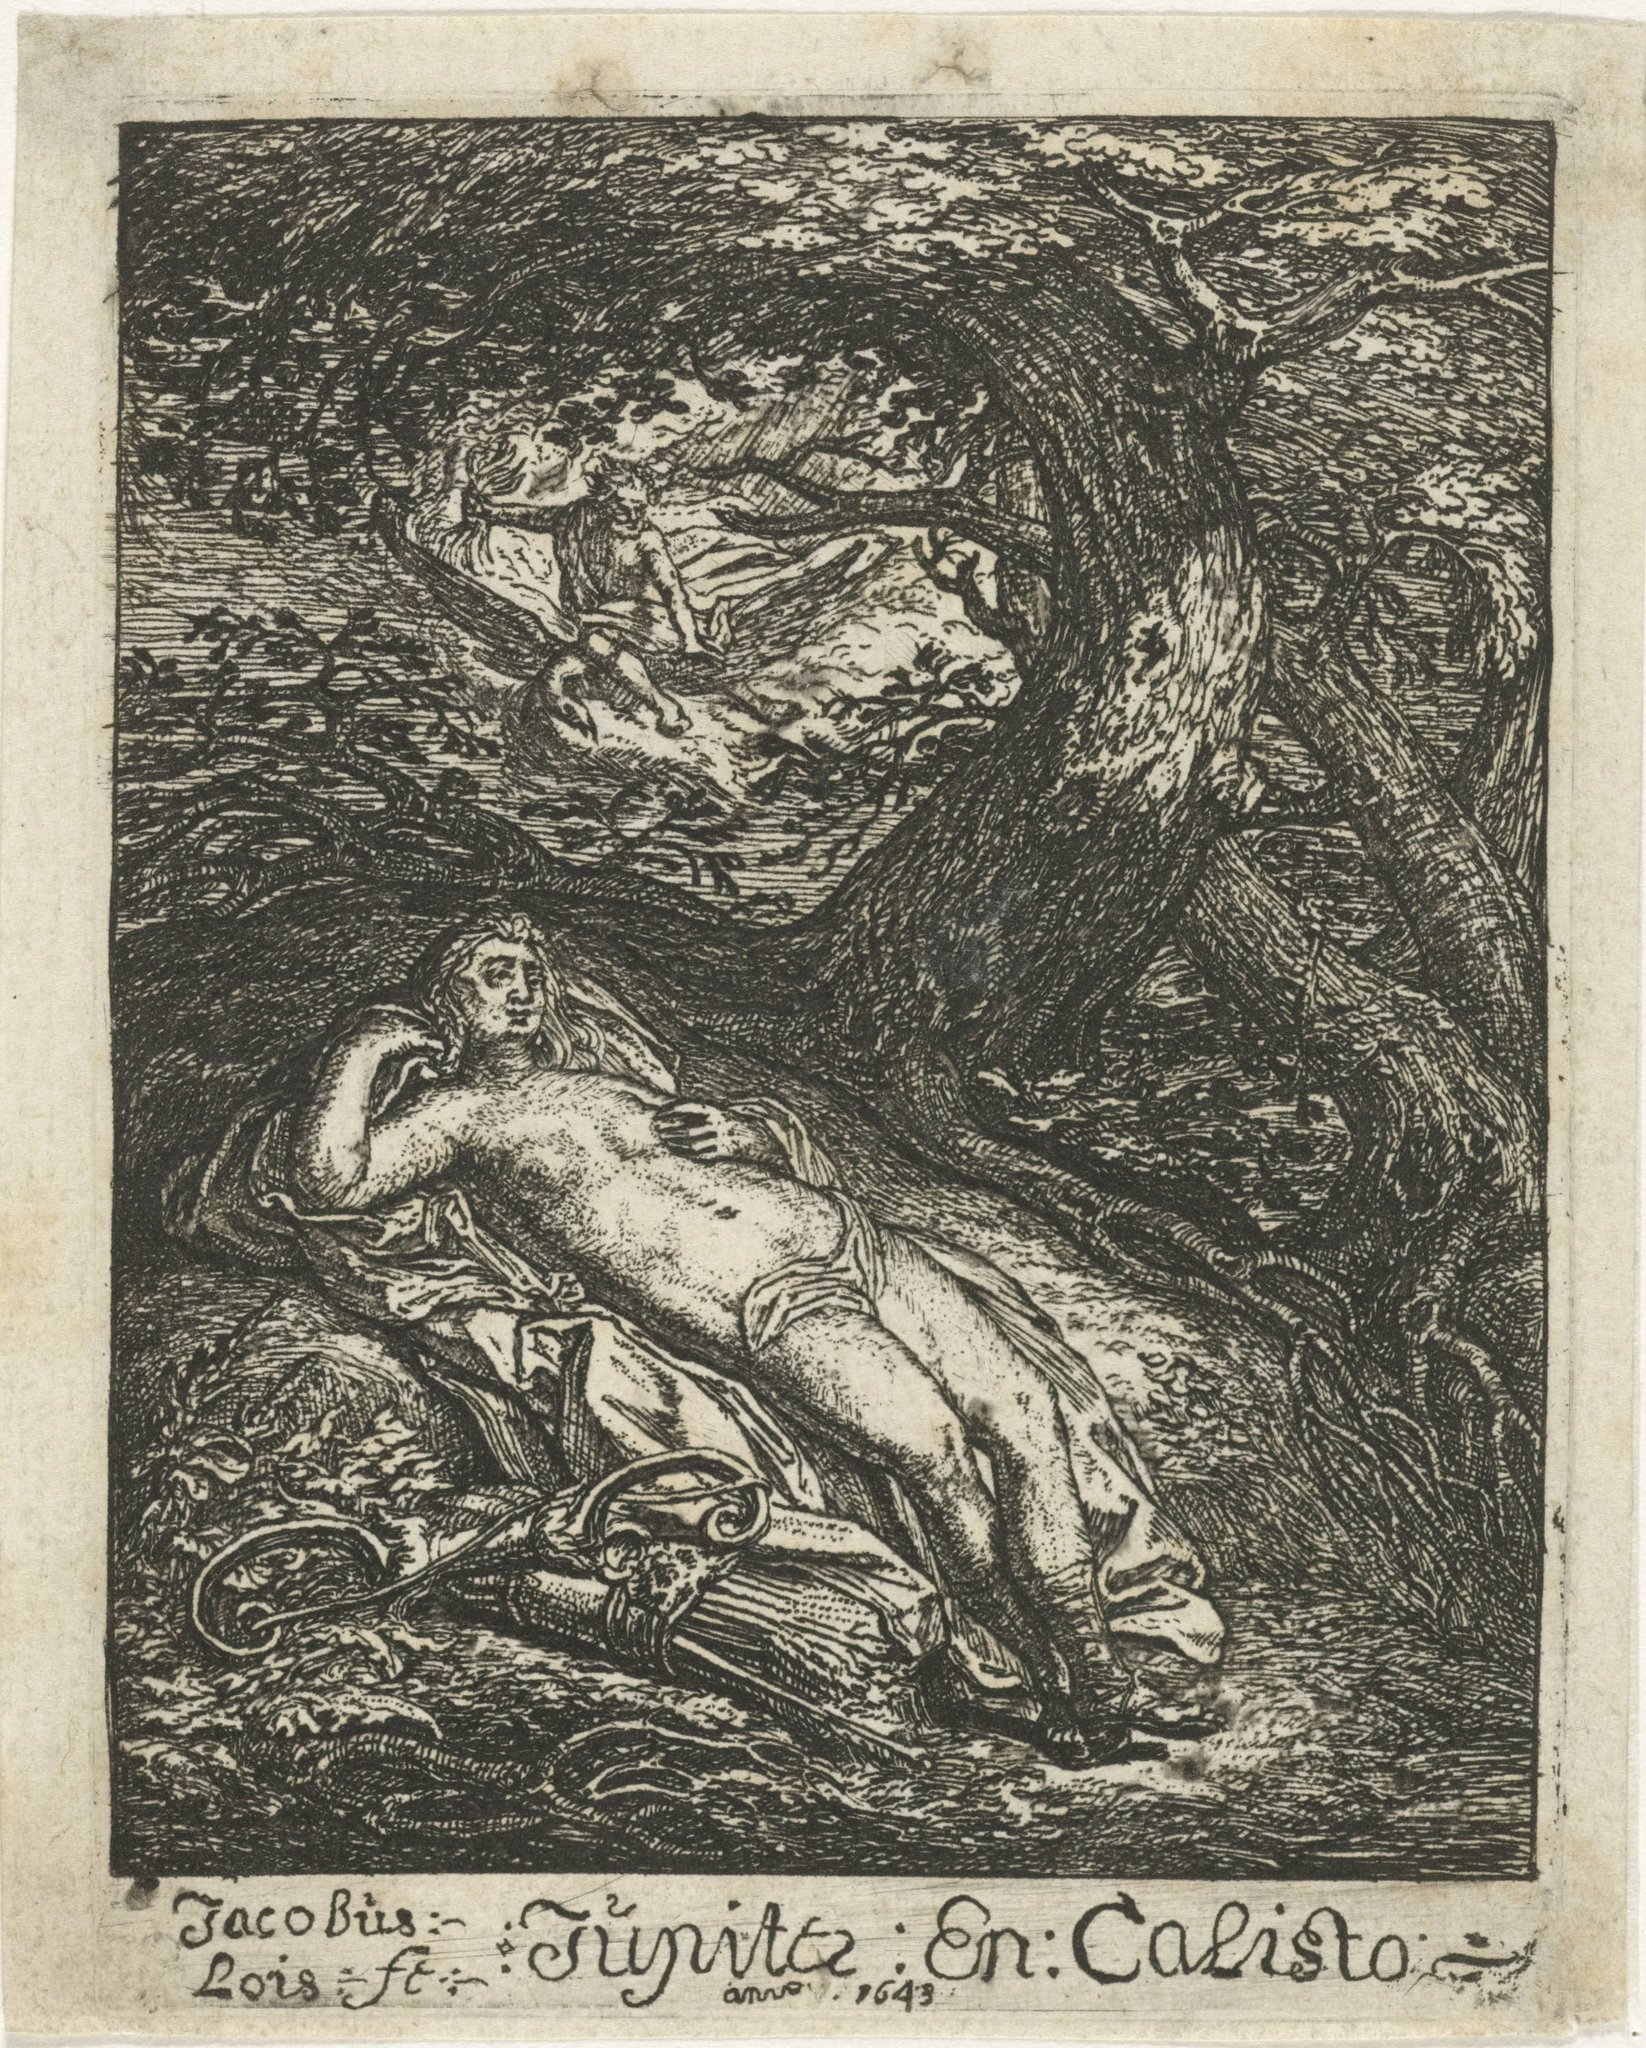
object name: print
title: Jupiter en Callisto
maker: jacob lois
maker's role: draughtsman, print maker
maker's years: -1676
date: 1643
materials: paper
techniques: etching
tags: jupiter, in the guise of diana, and callisto, homosexual love - cc - homosexual love between women: lesbianism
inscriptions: collector's mark: Lugt 2228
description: Callisto ligt bijna geheel naakt in een bos tegen een heuvel te rusten met een boog en pijlenkoker naast haar. Op de achtergrond komt Jupiter, gezeten op zijn arend, naderbij.